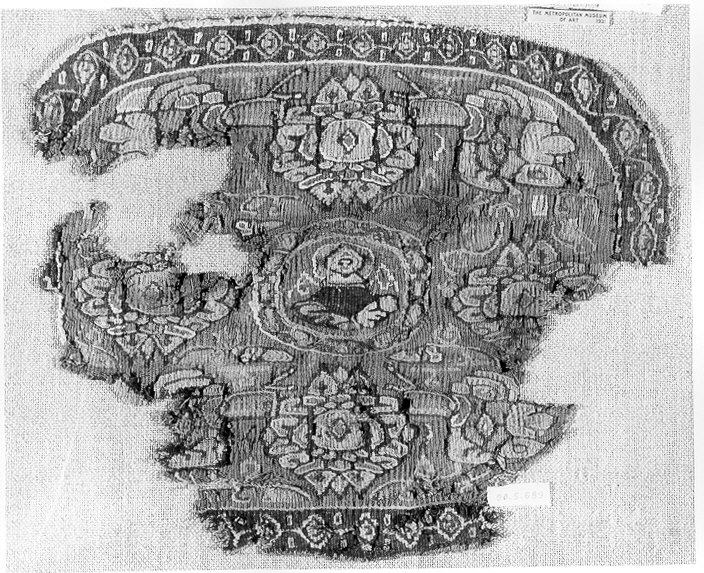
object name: textile fragment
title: Tunic Ornament Showing Christ and the Virgin Flanked by Angels?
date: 601-800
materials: linen, wool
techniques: weave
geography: egypt